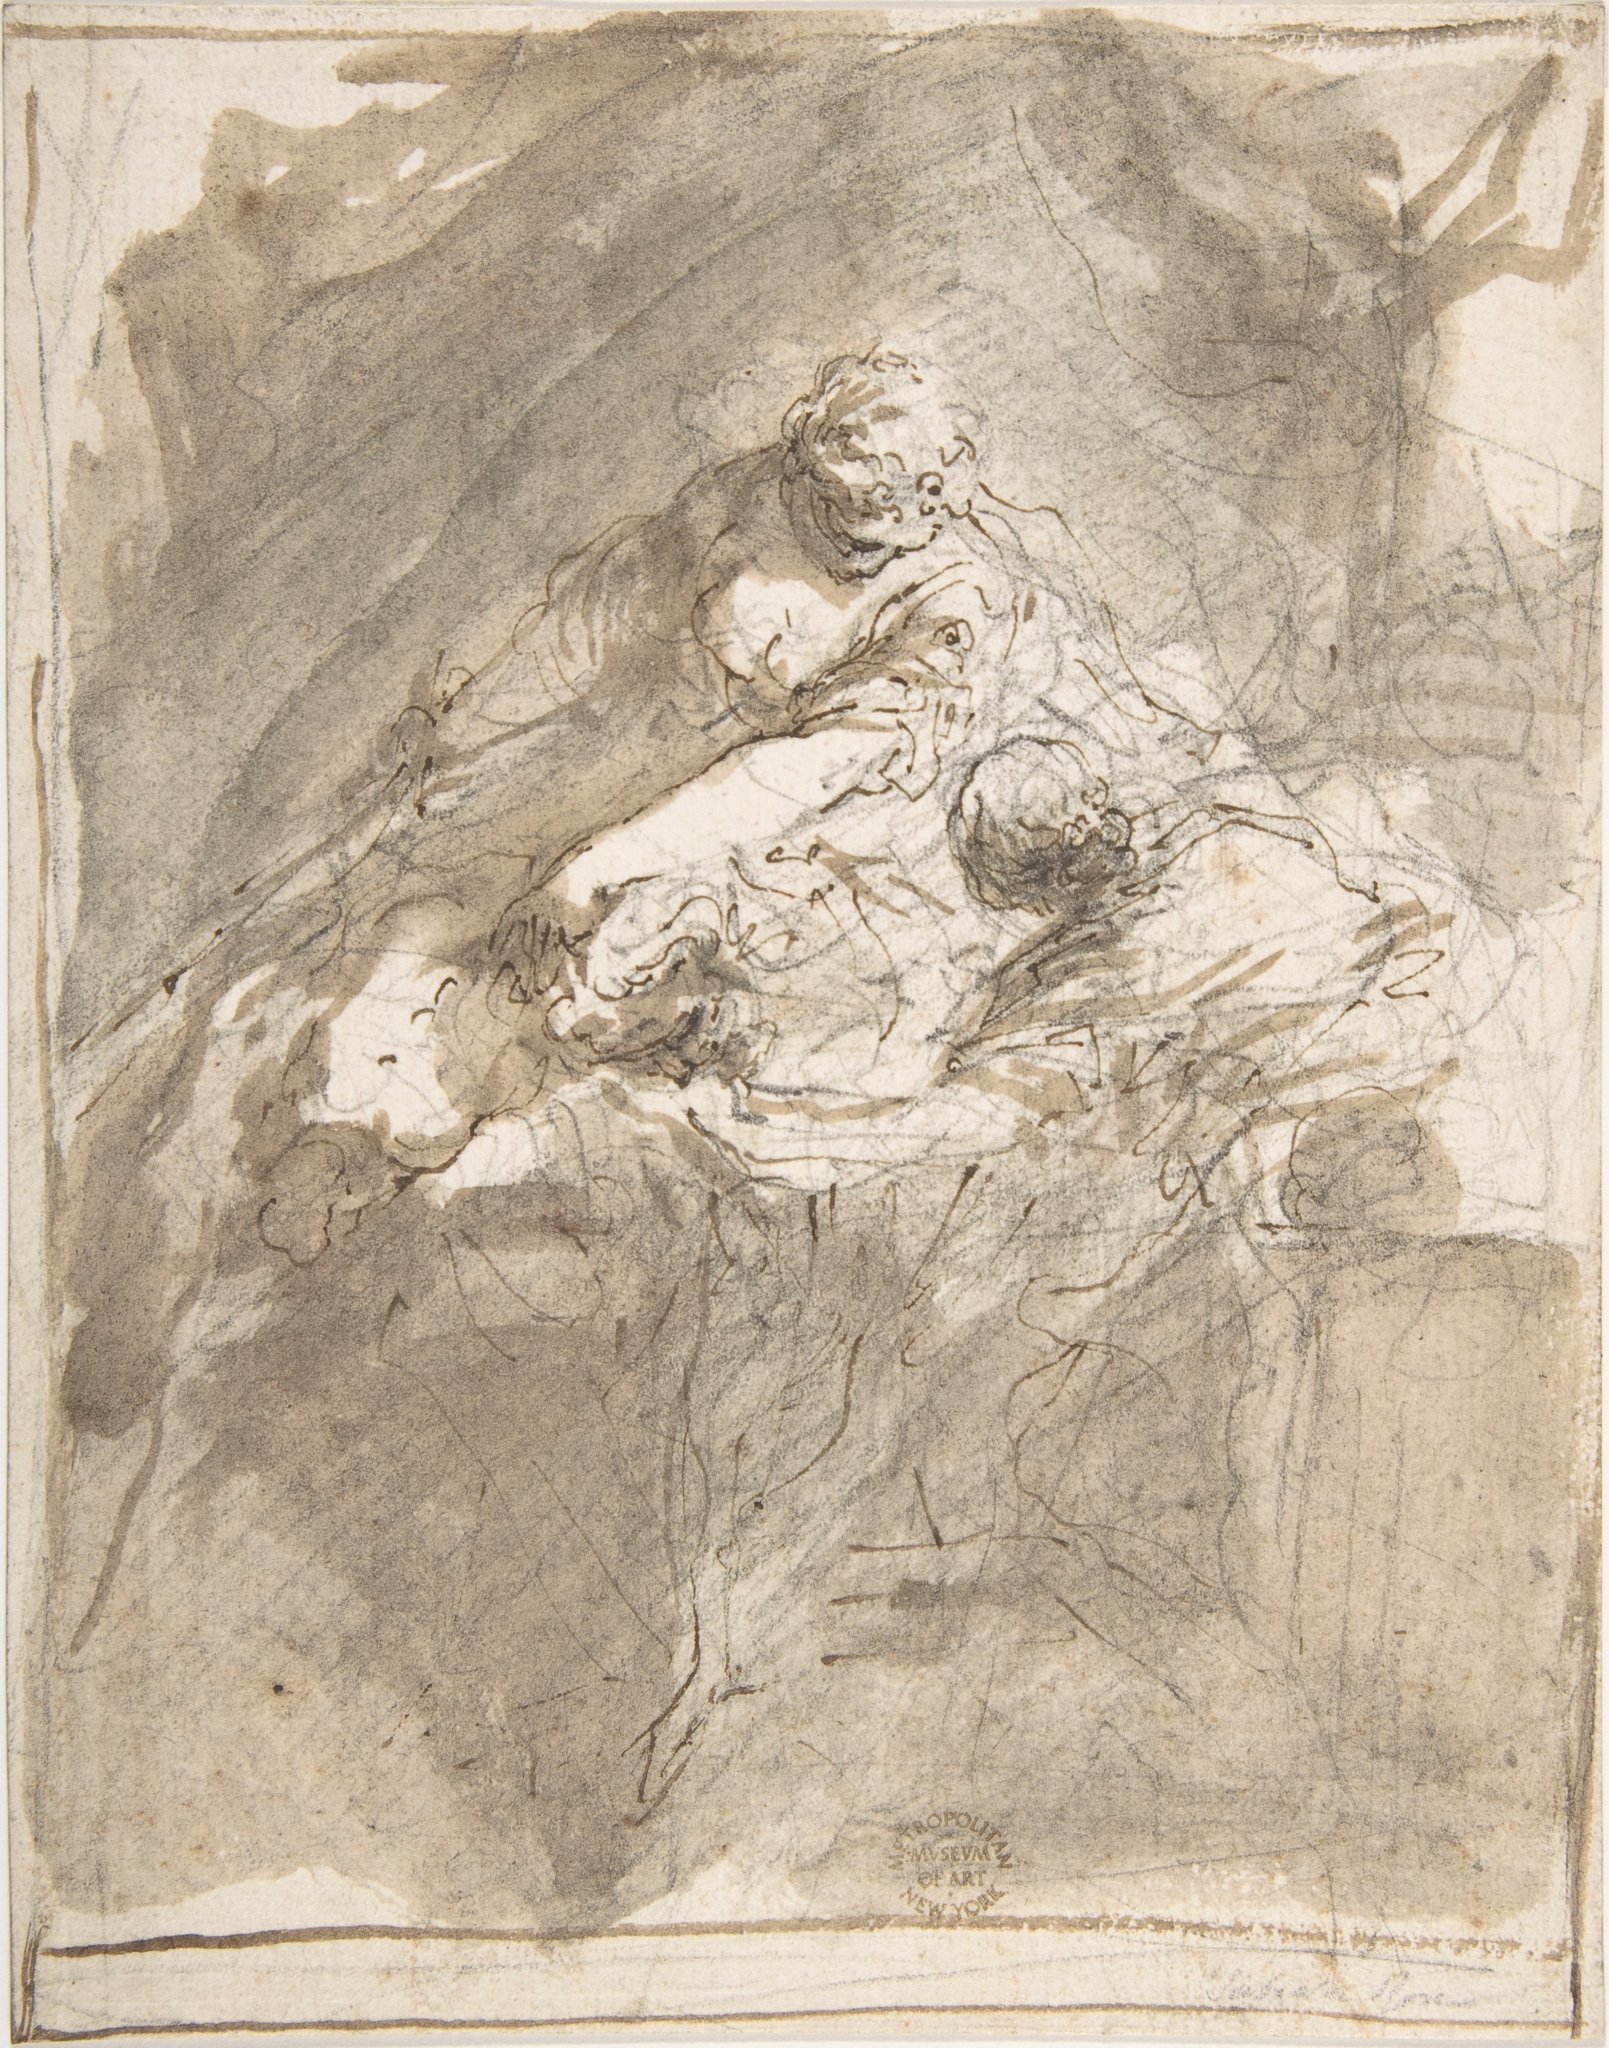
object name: drawing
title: Judith Decapitating Holofernes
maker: valerio castello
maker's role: artist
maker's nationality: italian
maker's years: 1624-1659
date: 1624-1659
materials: chalk, ink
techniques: brush, pen, wash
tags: holofernes,judith